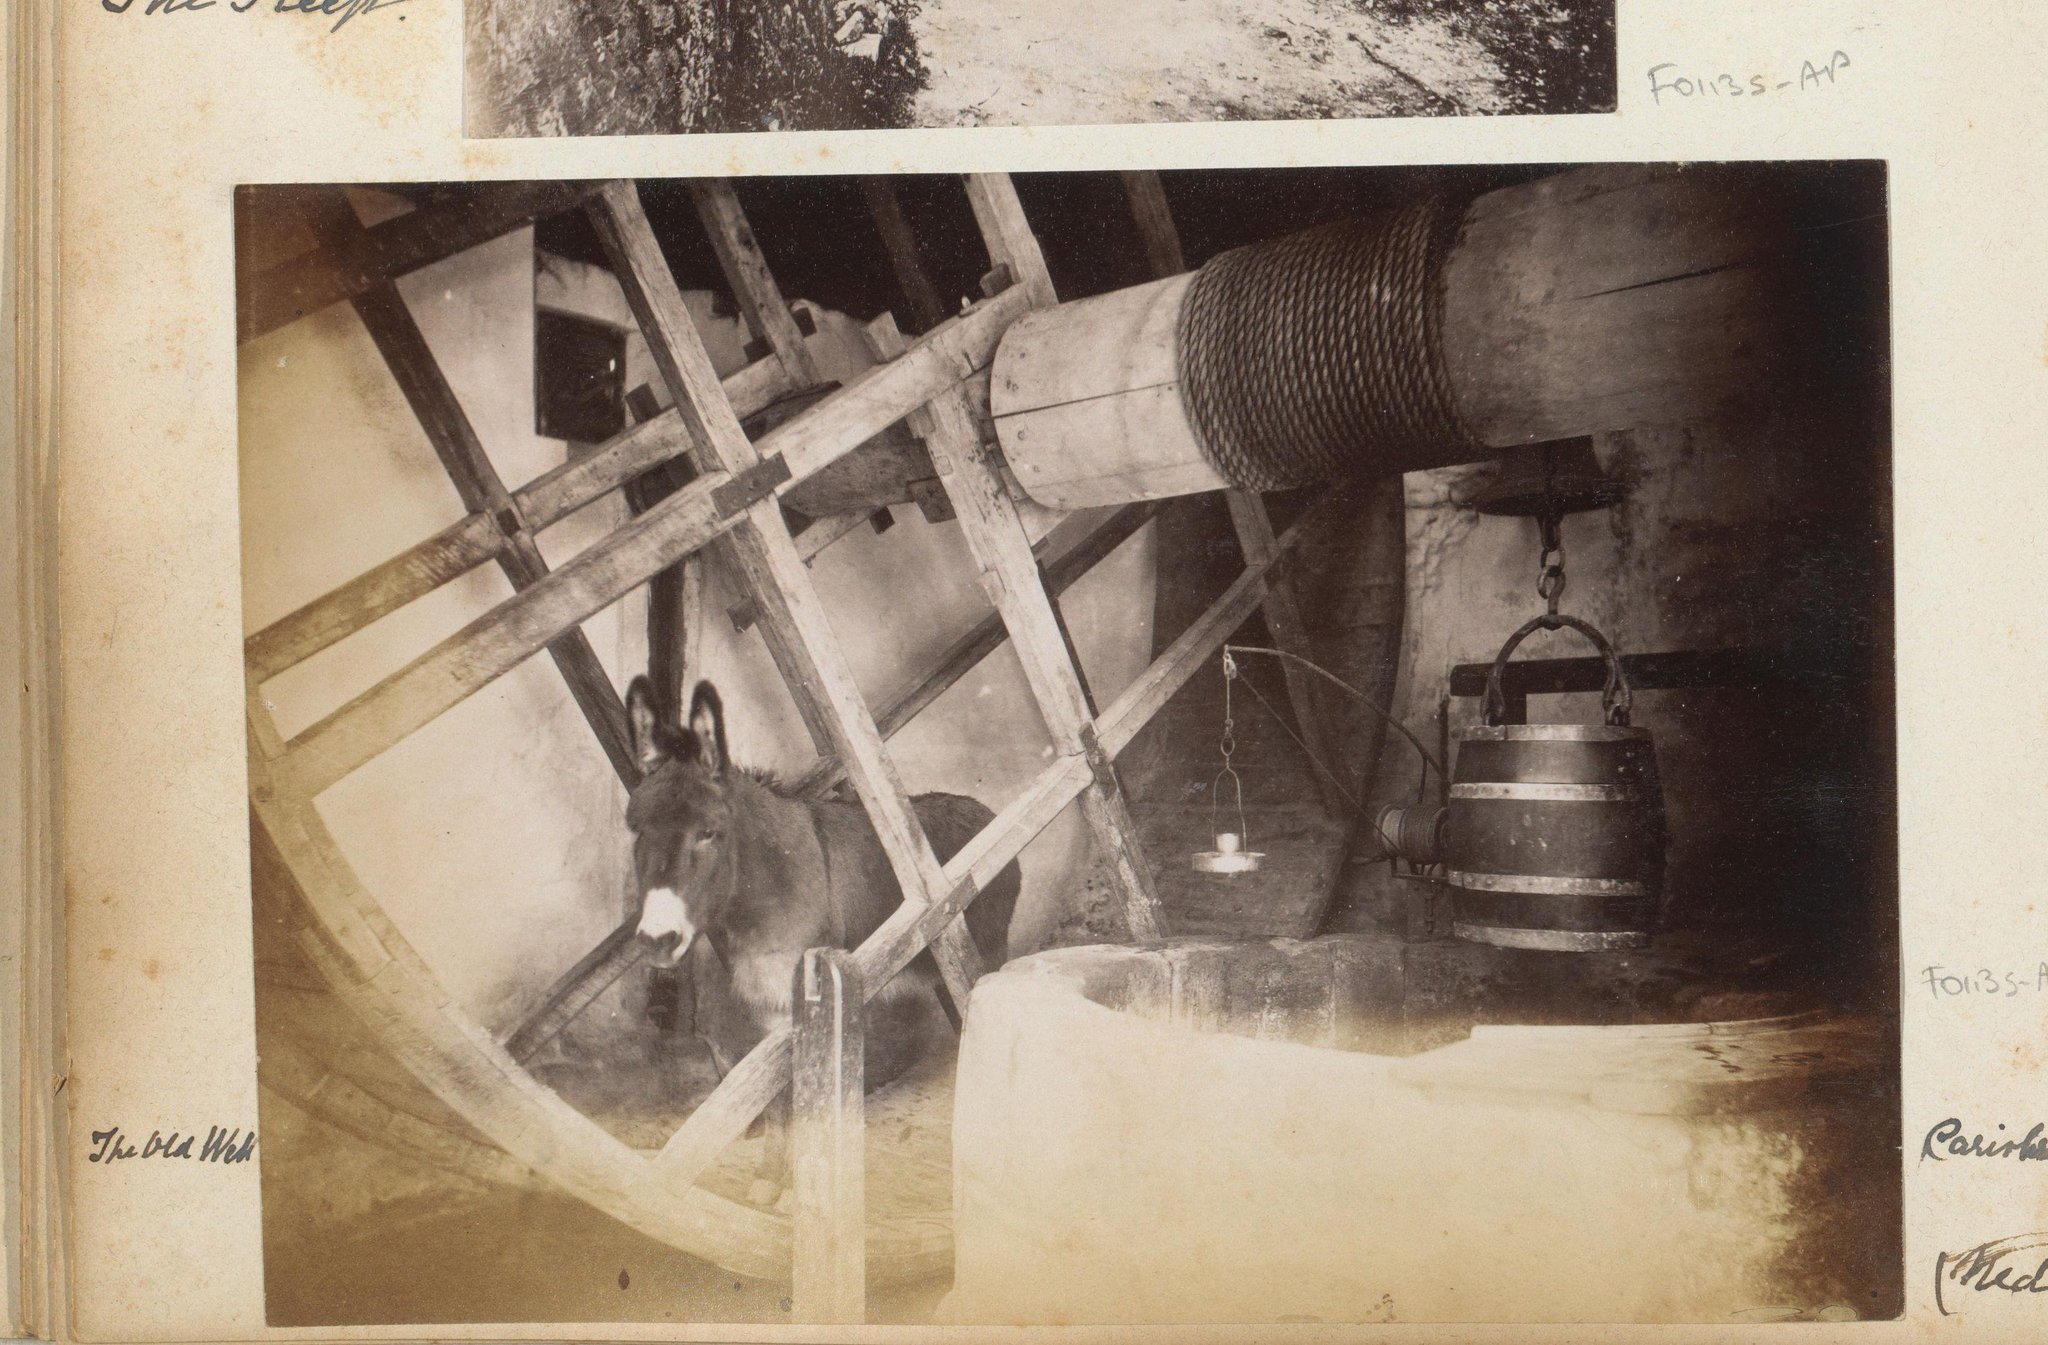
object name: photograph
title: Verdedigingswerk met trap (The Keep) van het kasteel van Carisbrooke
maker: Anonymous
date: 1898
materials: paper, photographic support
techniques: albumen print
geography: carisbrooke castle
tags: castle, gate, entrance, permanent fortifications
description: Onderdeel van Reisalbum met foto's van bezienswaardigheden in Engeland en Frankrijk.